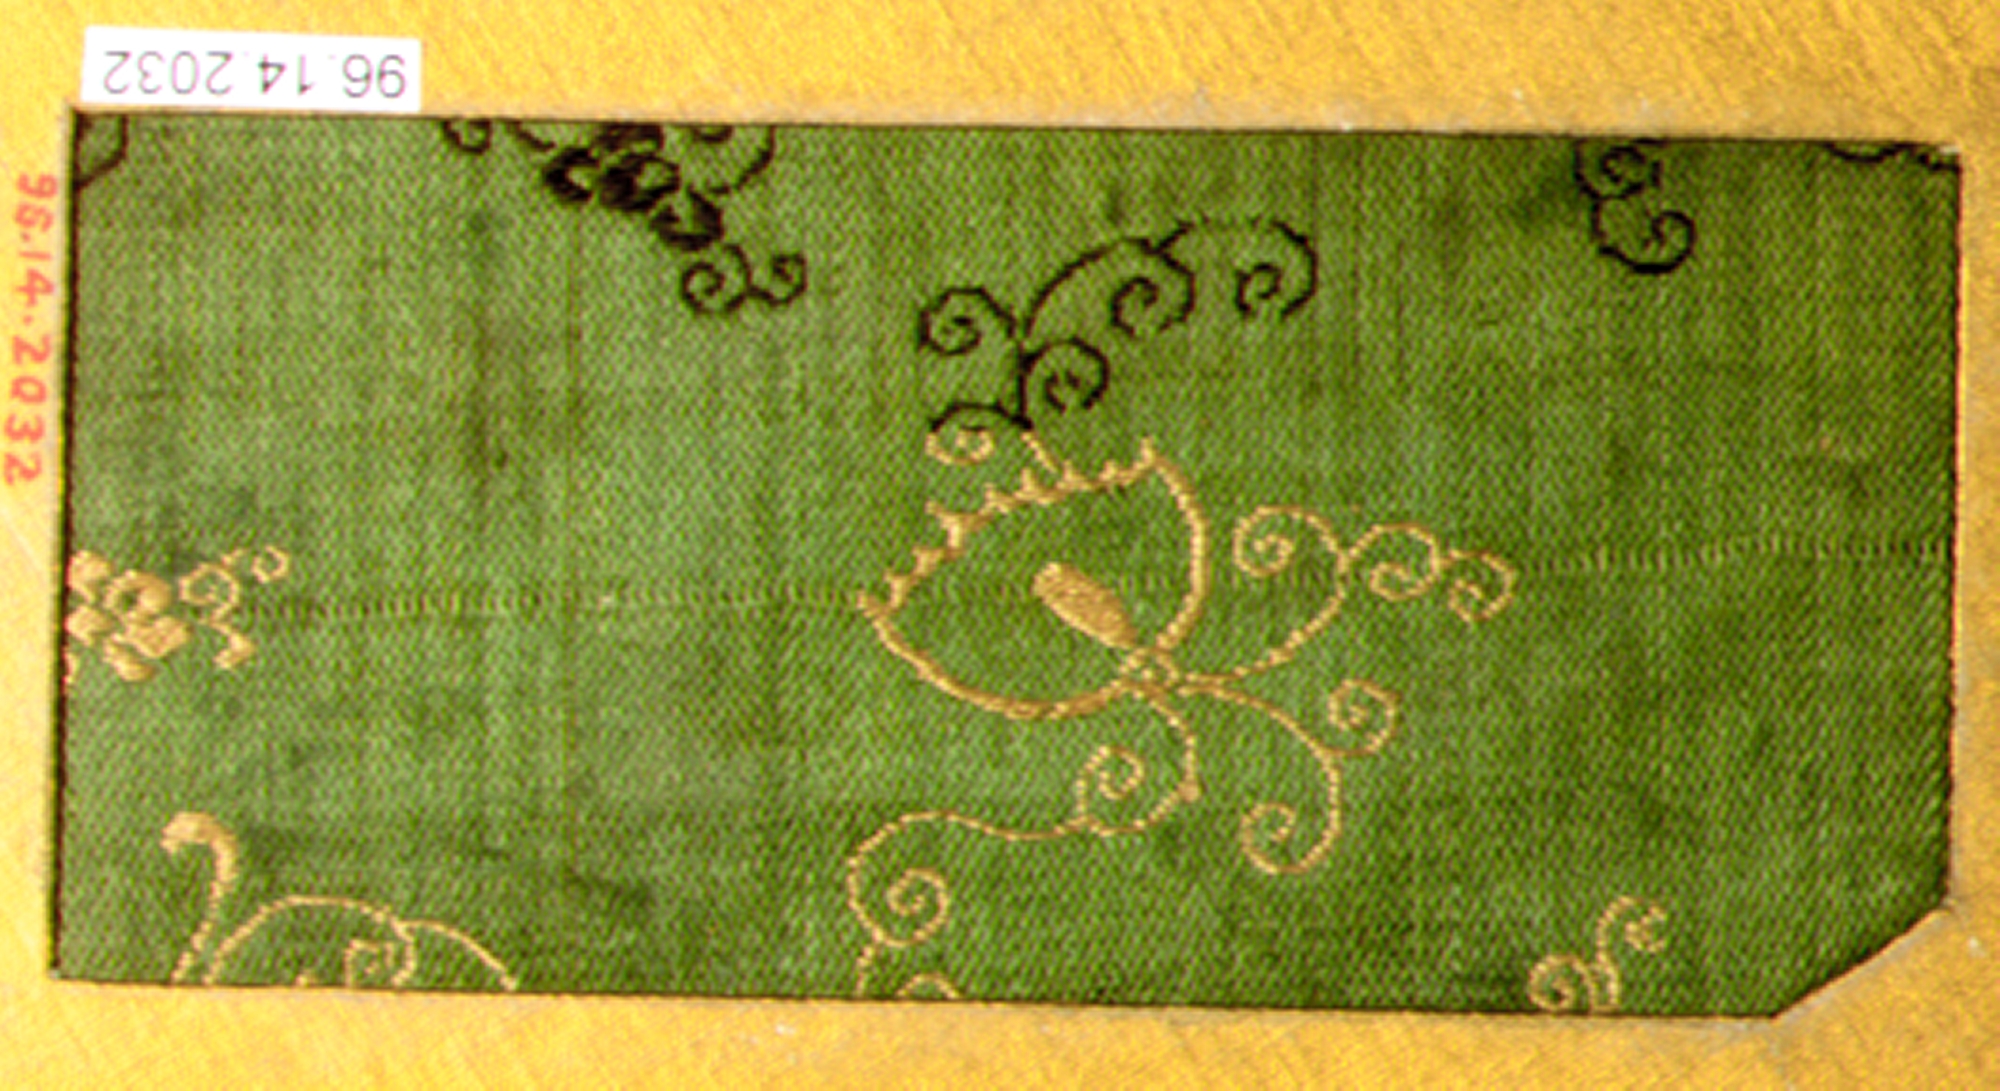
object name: piece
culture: japanese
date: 1701-1900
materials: silk